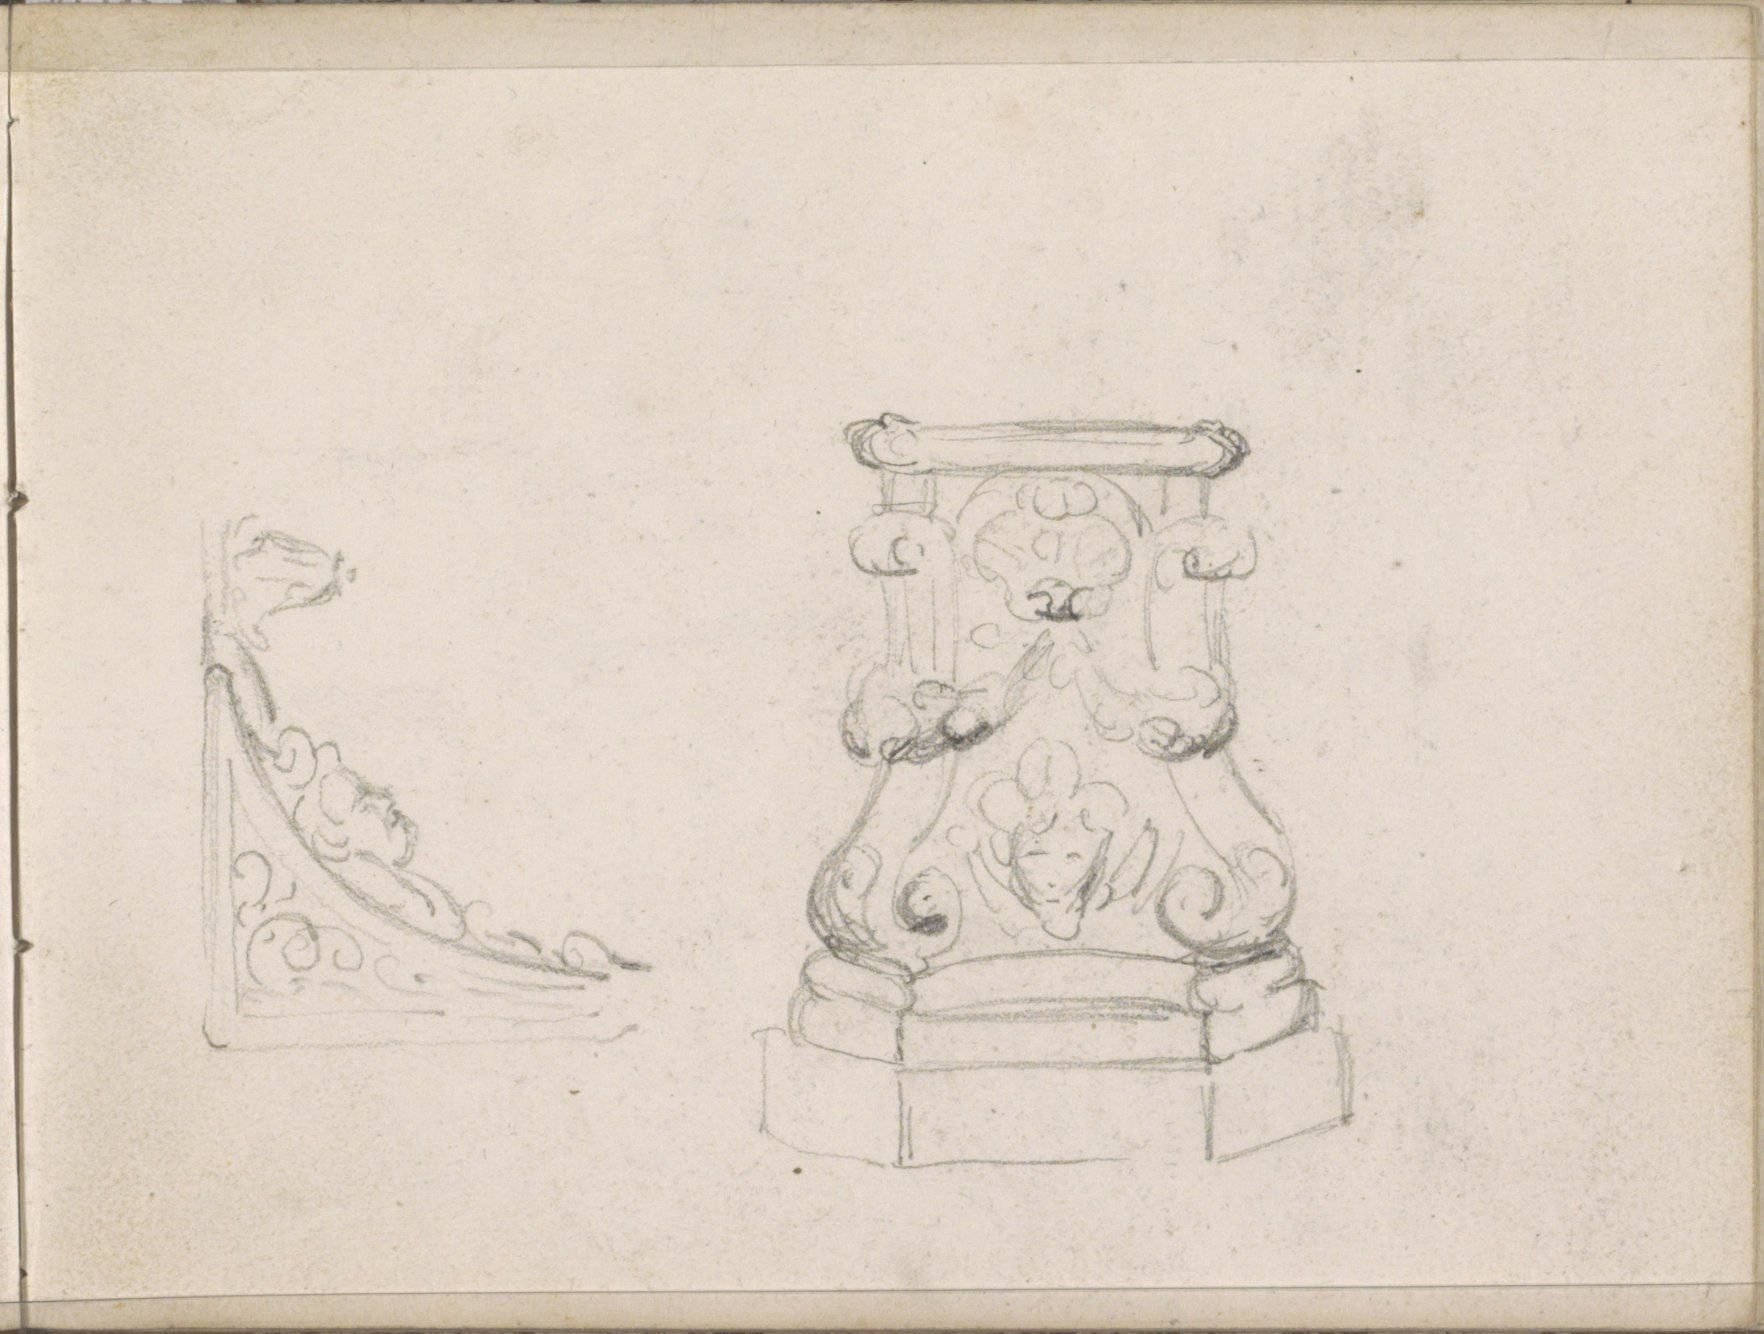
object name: sketchbook leaf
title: Decoratiemotief en een versierd basement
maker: maria vos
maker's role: draughtsman, painter, print maker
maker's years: 1824-1906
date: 1834-1906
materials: paper, pencil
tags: base (~ column, pillar)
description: Blad 14 recto uit een schetsboek met 21 bladen.